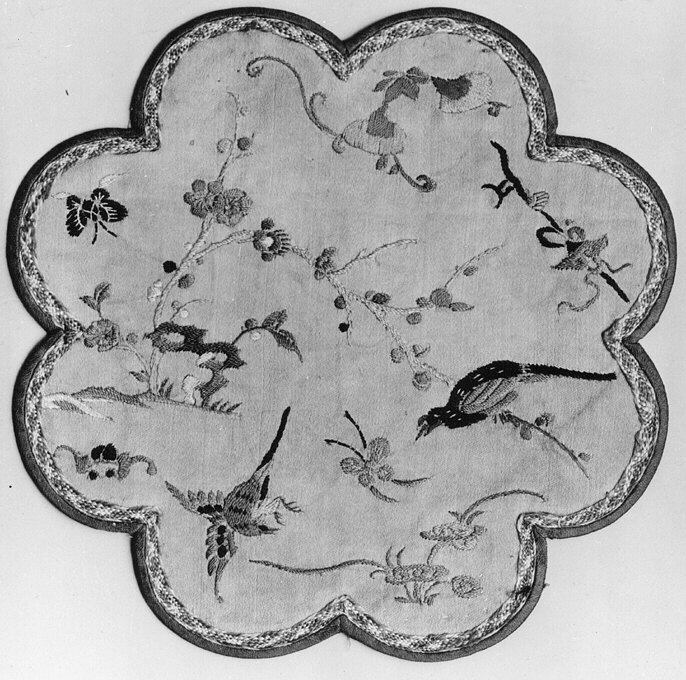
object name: medallion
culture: chinese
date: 1644-1911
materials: silk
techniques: bookbinding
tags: birds,butterflies